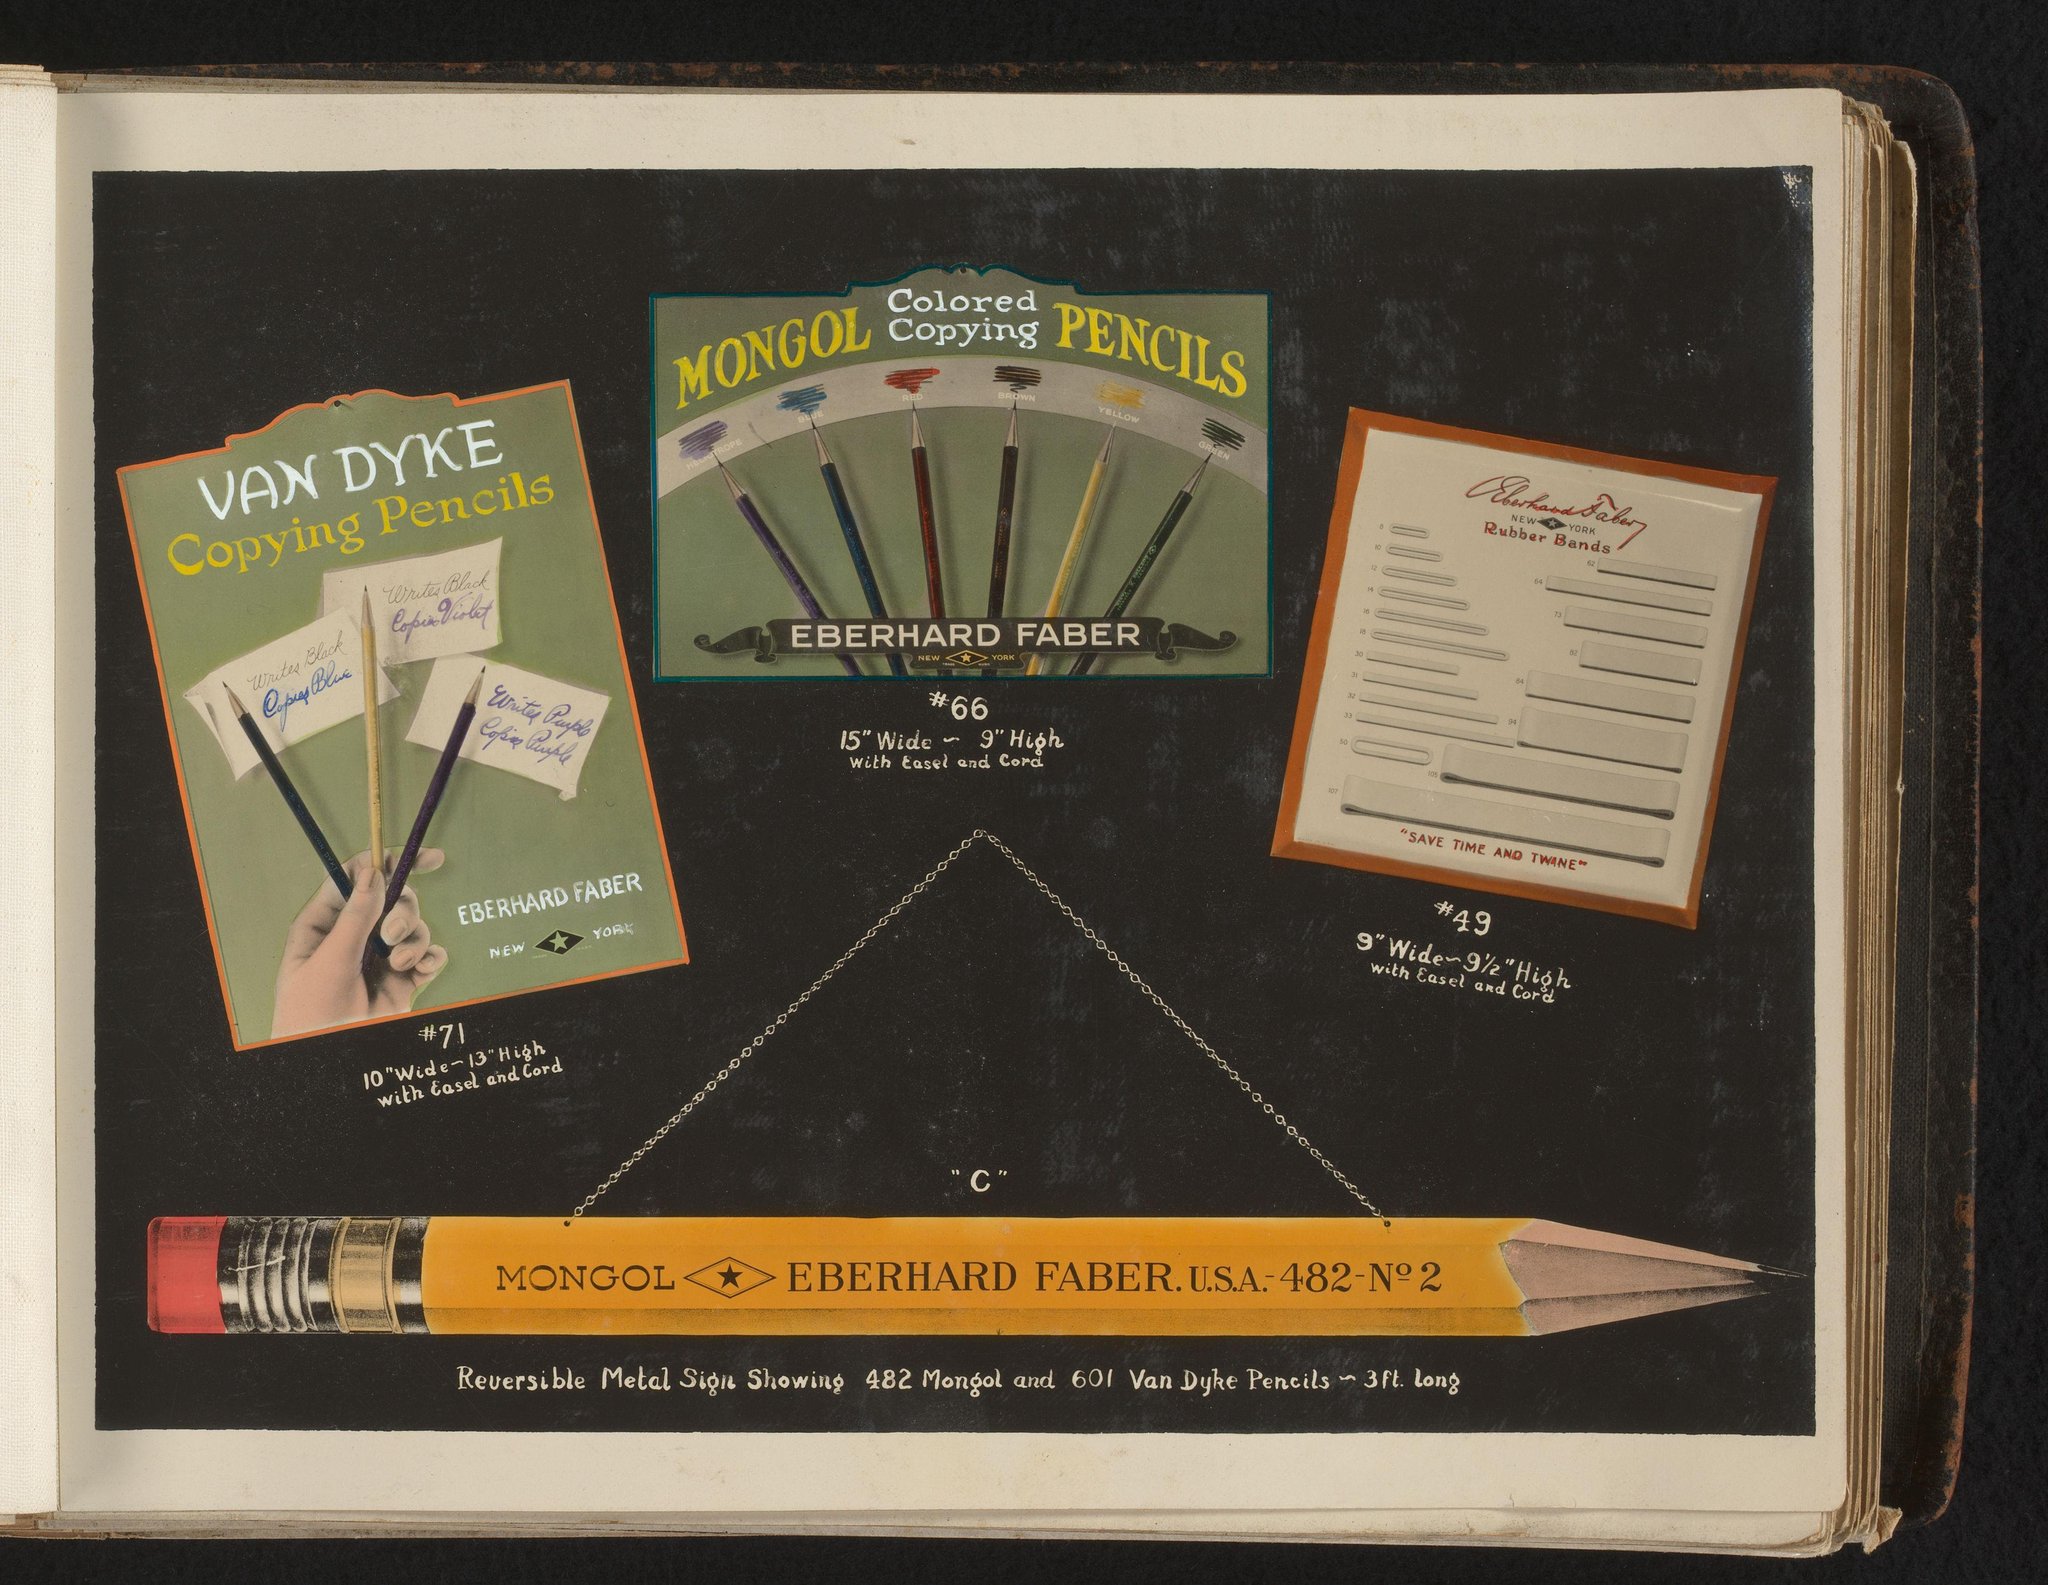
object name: album leaf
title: Reclamemateriaal voor potloden van Eberhard Faber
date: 1915-1935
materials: paper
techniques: gelatin silver print, hand coloring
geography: springfield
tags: pencil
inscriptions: stamp: ‘Paramount/ Commercial Studios/ 145 Chestnut St./ Springfield - Mass.’, number: ‘40’